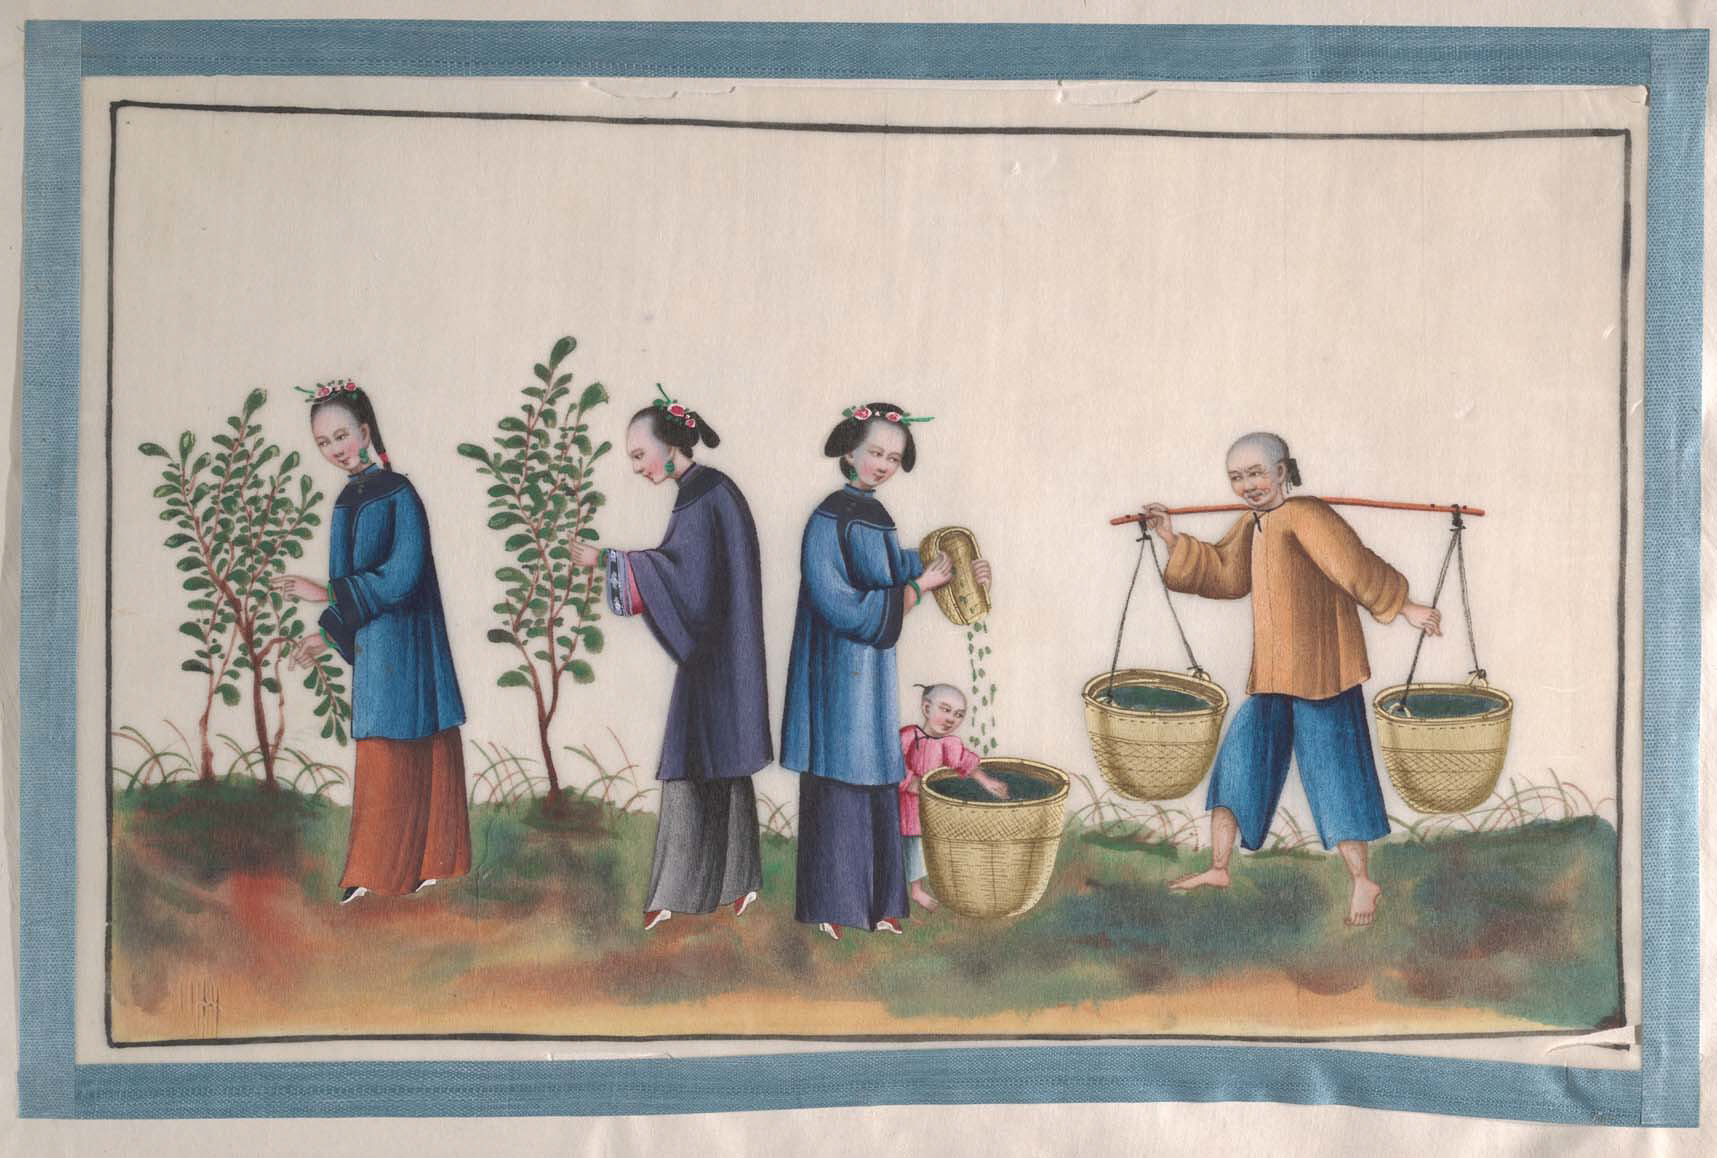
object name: album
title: Album Containing Twelve Paintings of People Making Silk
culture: chinese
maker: unidentified artist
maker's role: artist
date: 1801-1900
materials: paper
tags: children,men,women,working,industry